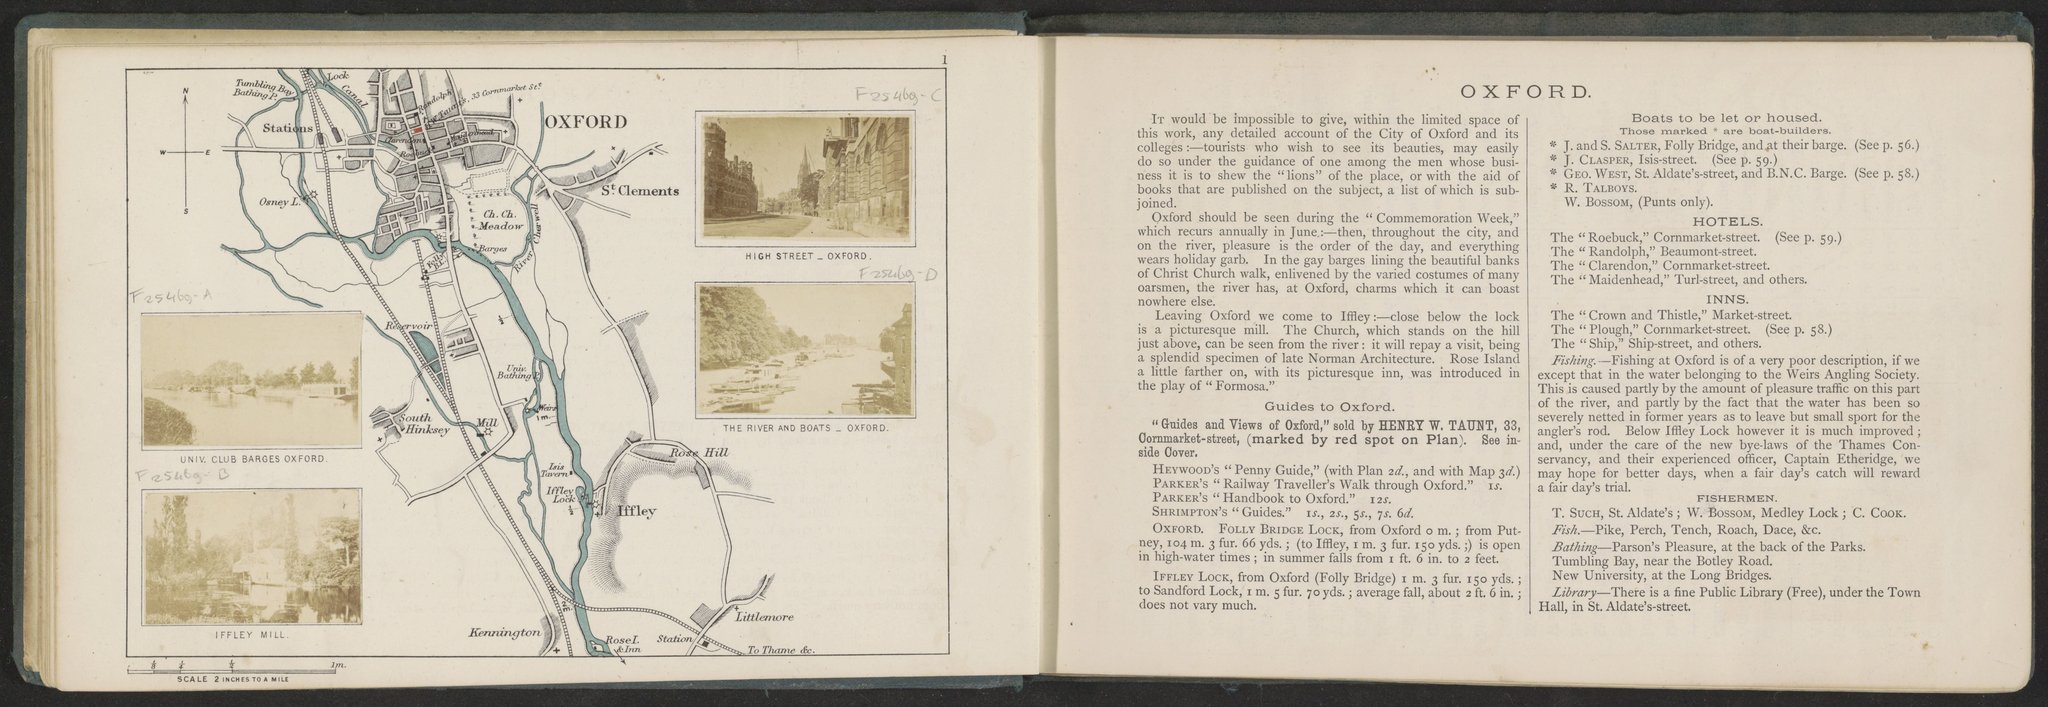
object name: page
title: High Street, Oxford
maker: henry w. taunt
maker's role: fotograaf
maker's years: 1842-1922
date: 1871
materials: photographic support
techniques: albumen print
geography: oxford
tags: street